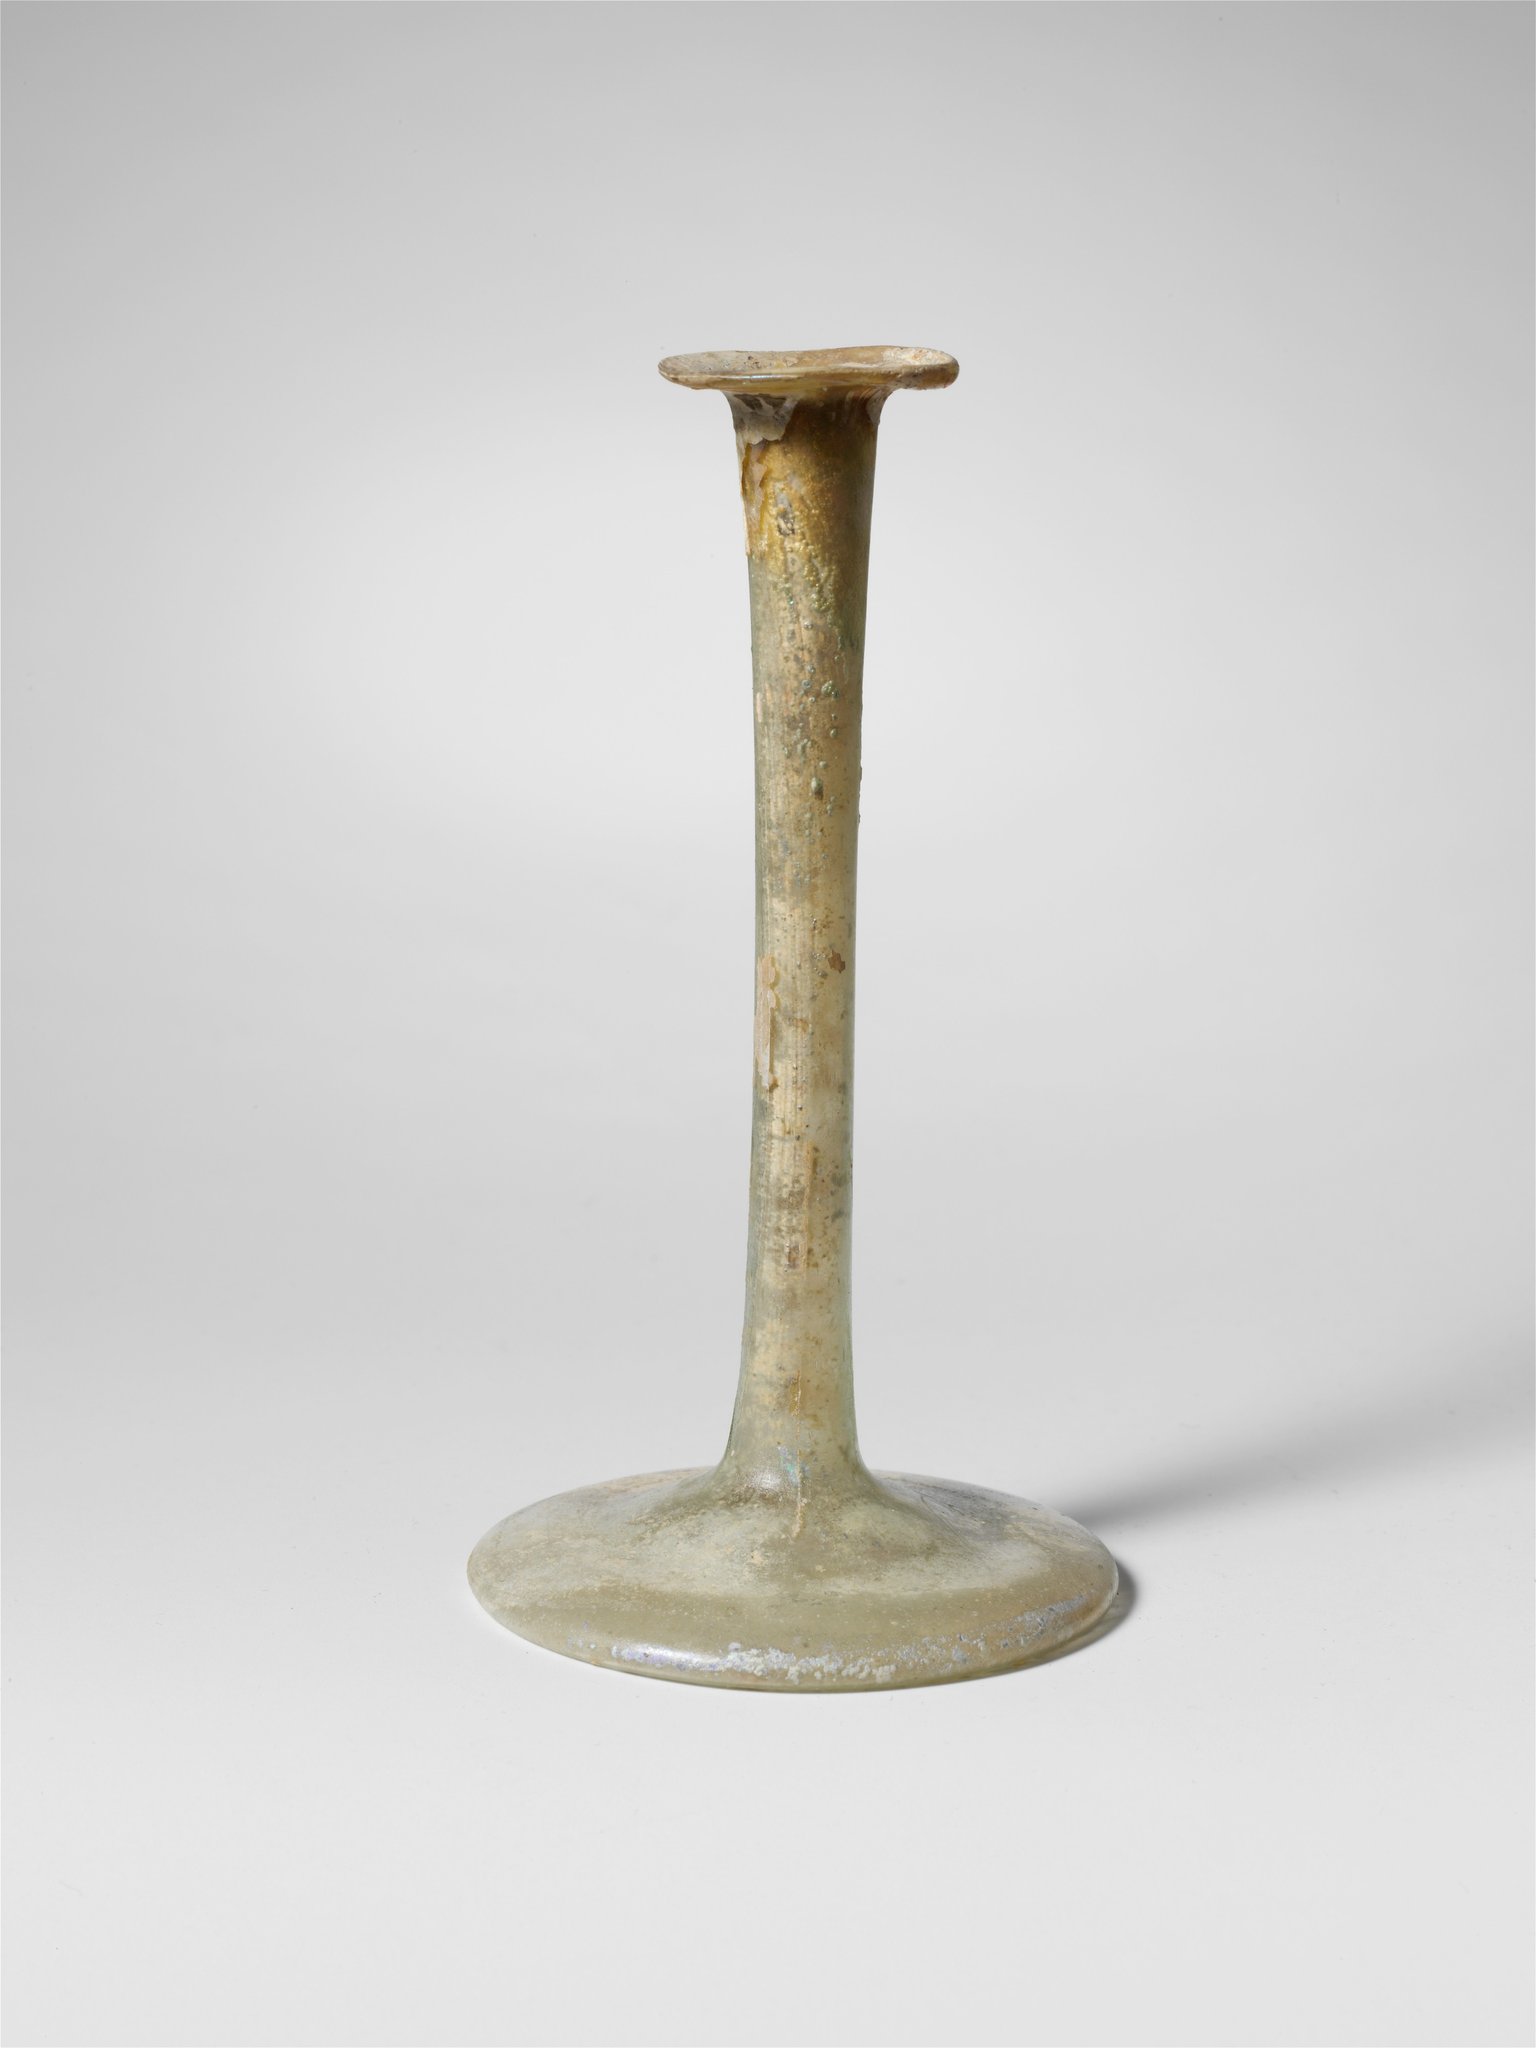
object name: candlestick perfume bottle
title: Glass perfume bottle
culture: roman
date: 101-300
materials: glass